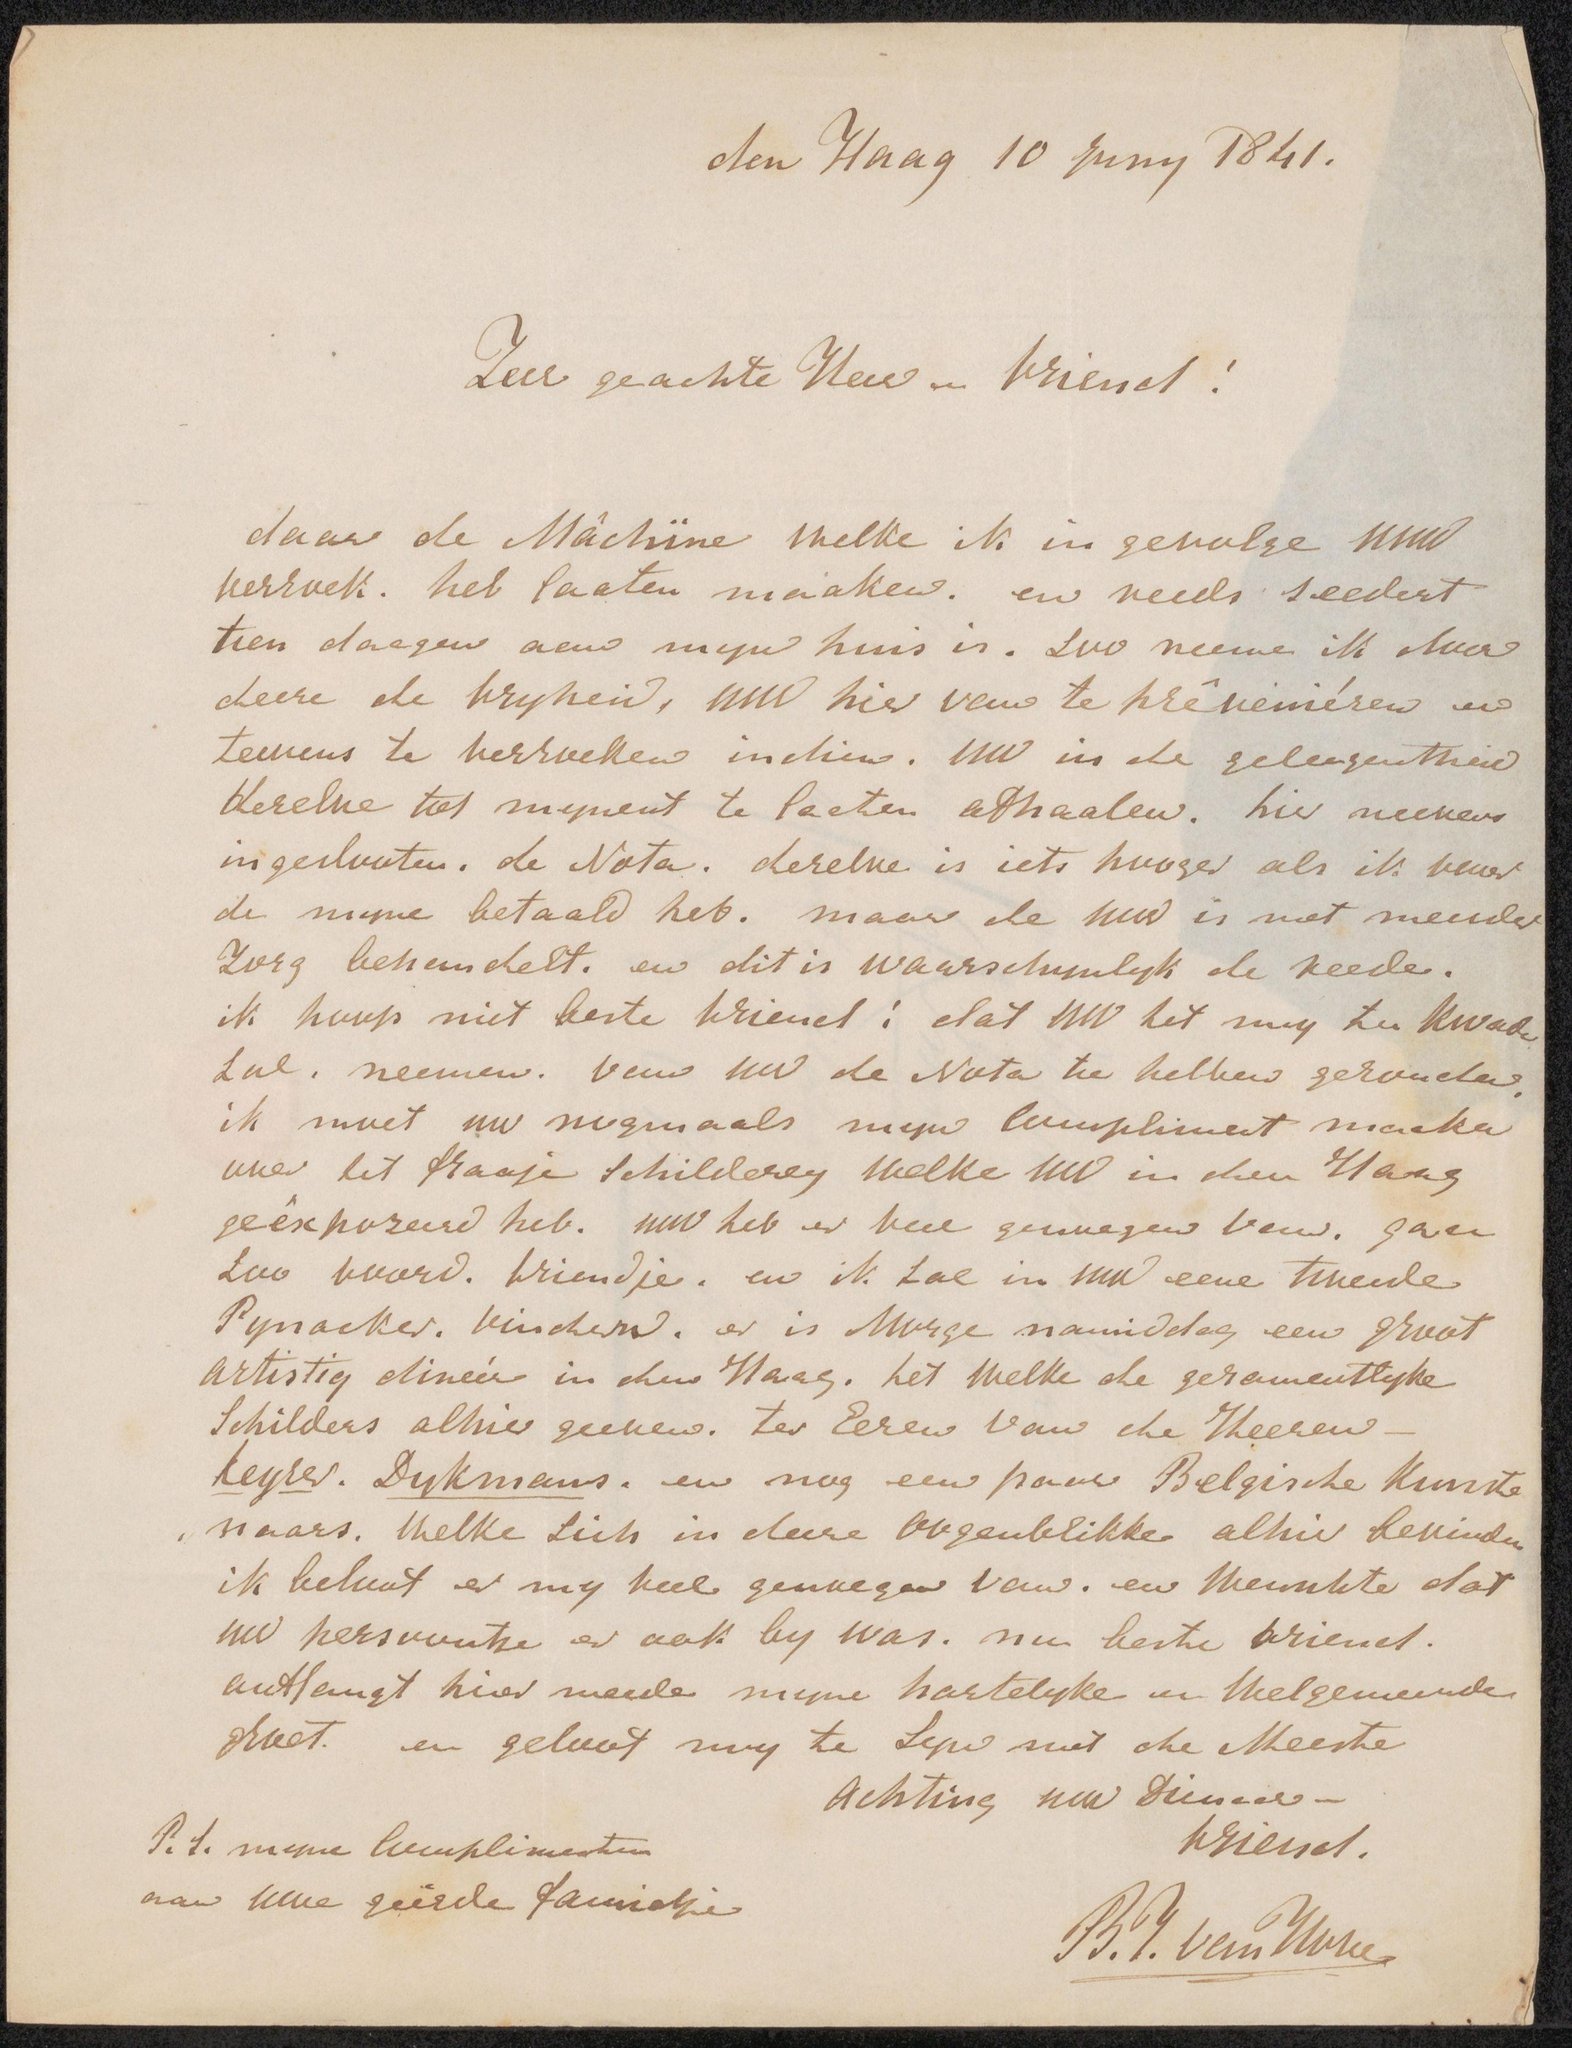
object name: letter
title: Brief aan Christiaan Immerzeel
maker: bartholomeus johannes van hove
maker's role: draughtsman, painter, print maker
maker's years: 1790-1880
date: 1841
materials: ink, paper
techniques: pen, writing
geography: the hague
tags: christiaan immerzeel, lierre, antwerp, joseph-laurens dijckmans, painting (including book-illumination, miniature-painting), exhibition ~ art, money, the hague